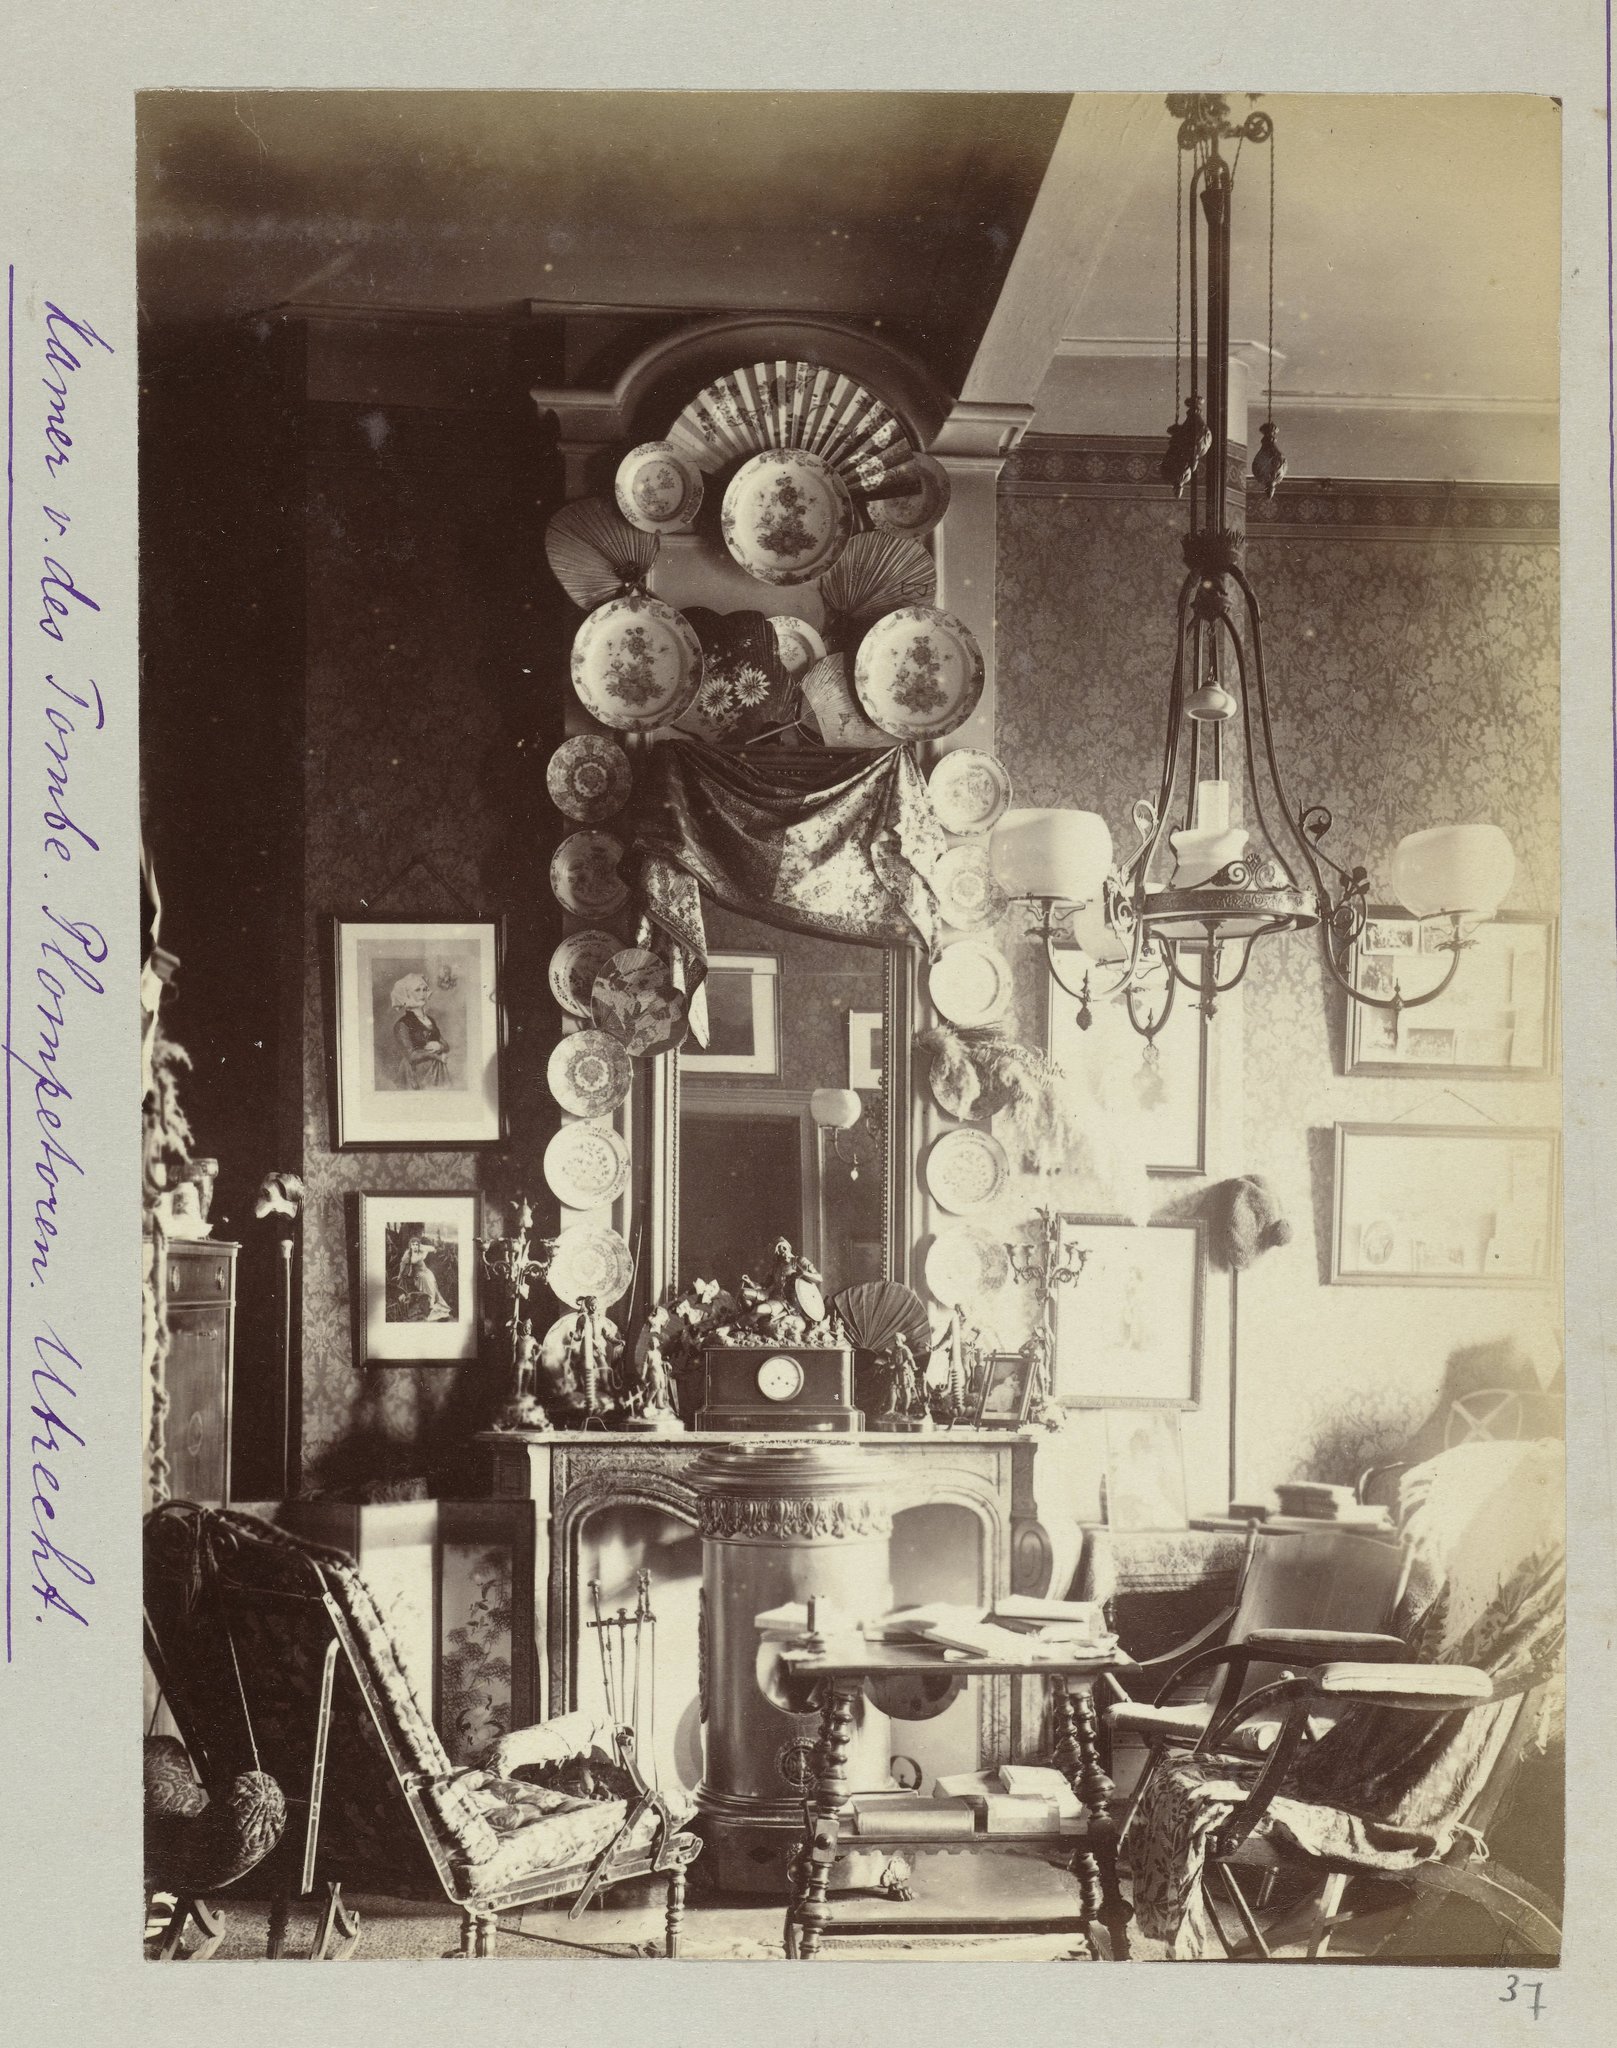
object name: photograph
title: Versierde kamer van J.W. des Tombe in Utrecht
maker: henry pauw van wieldrecht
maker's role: fotograaf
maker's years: 1863-1912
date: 1889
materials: paper, photographic support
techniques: albumen print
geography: netherlands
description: De rijk versierde kamer van des Tombe in Utrecht. Aan de wand onder andere sierborden, prenten en foto's. Links op het albumblad geschreven: Kamer v des Tombe Plompetoren. Utrecht.